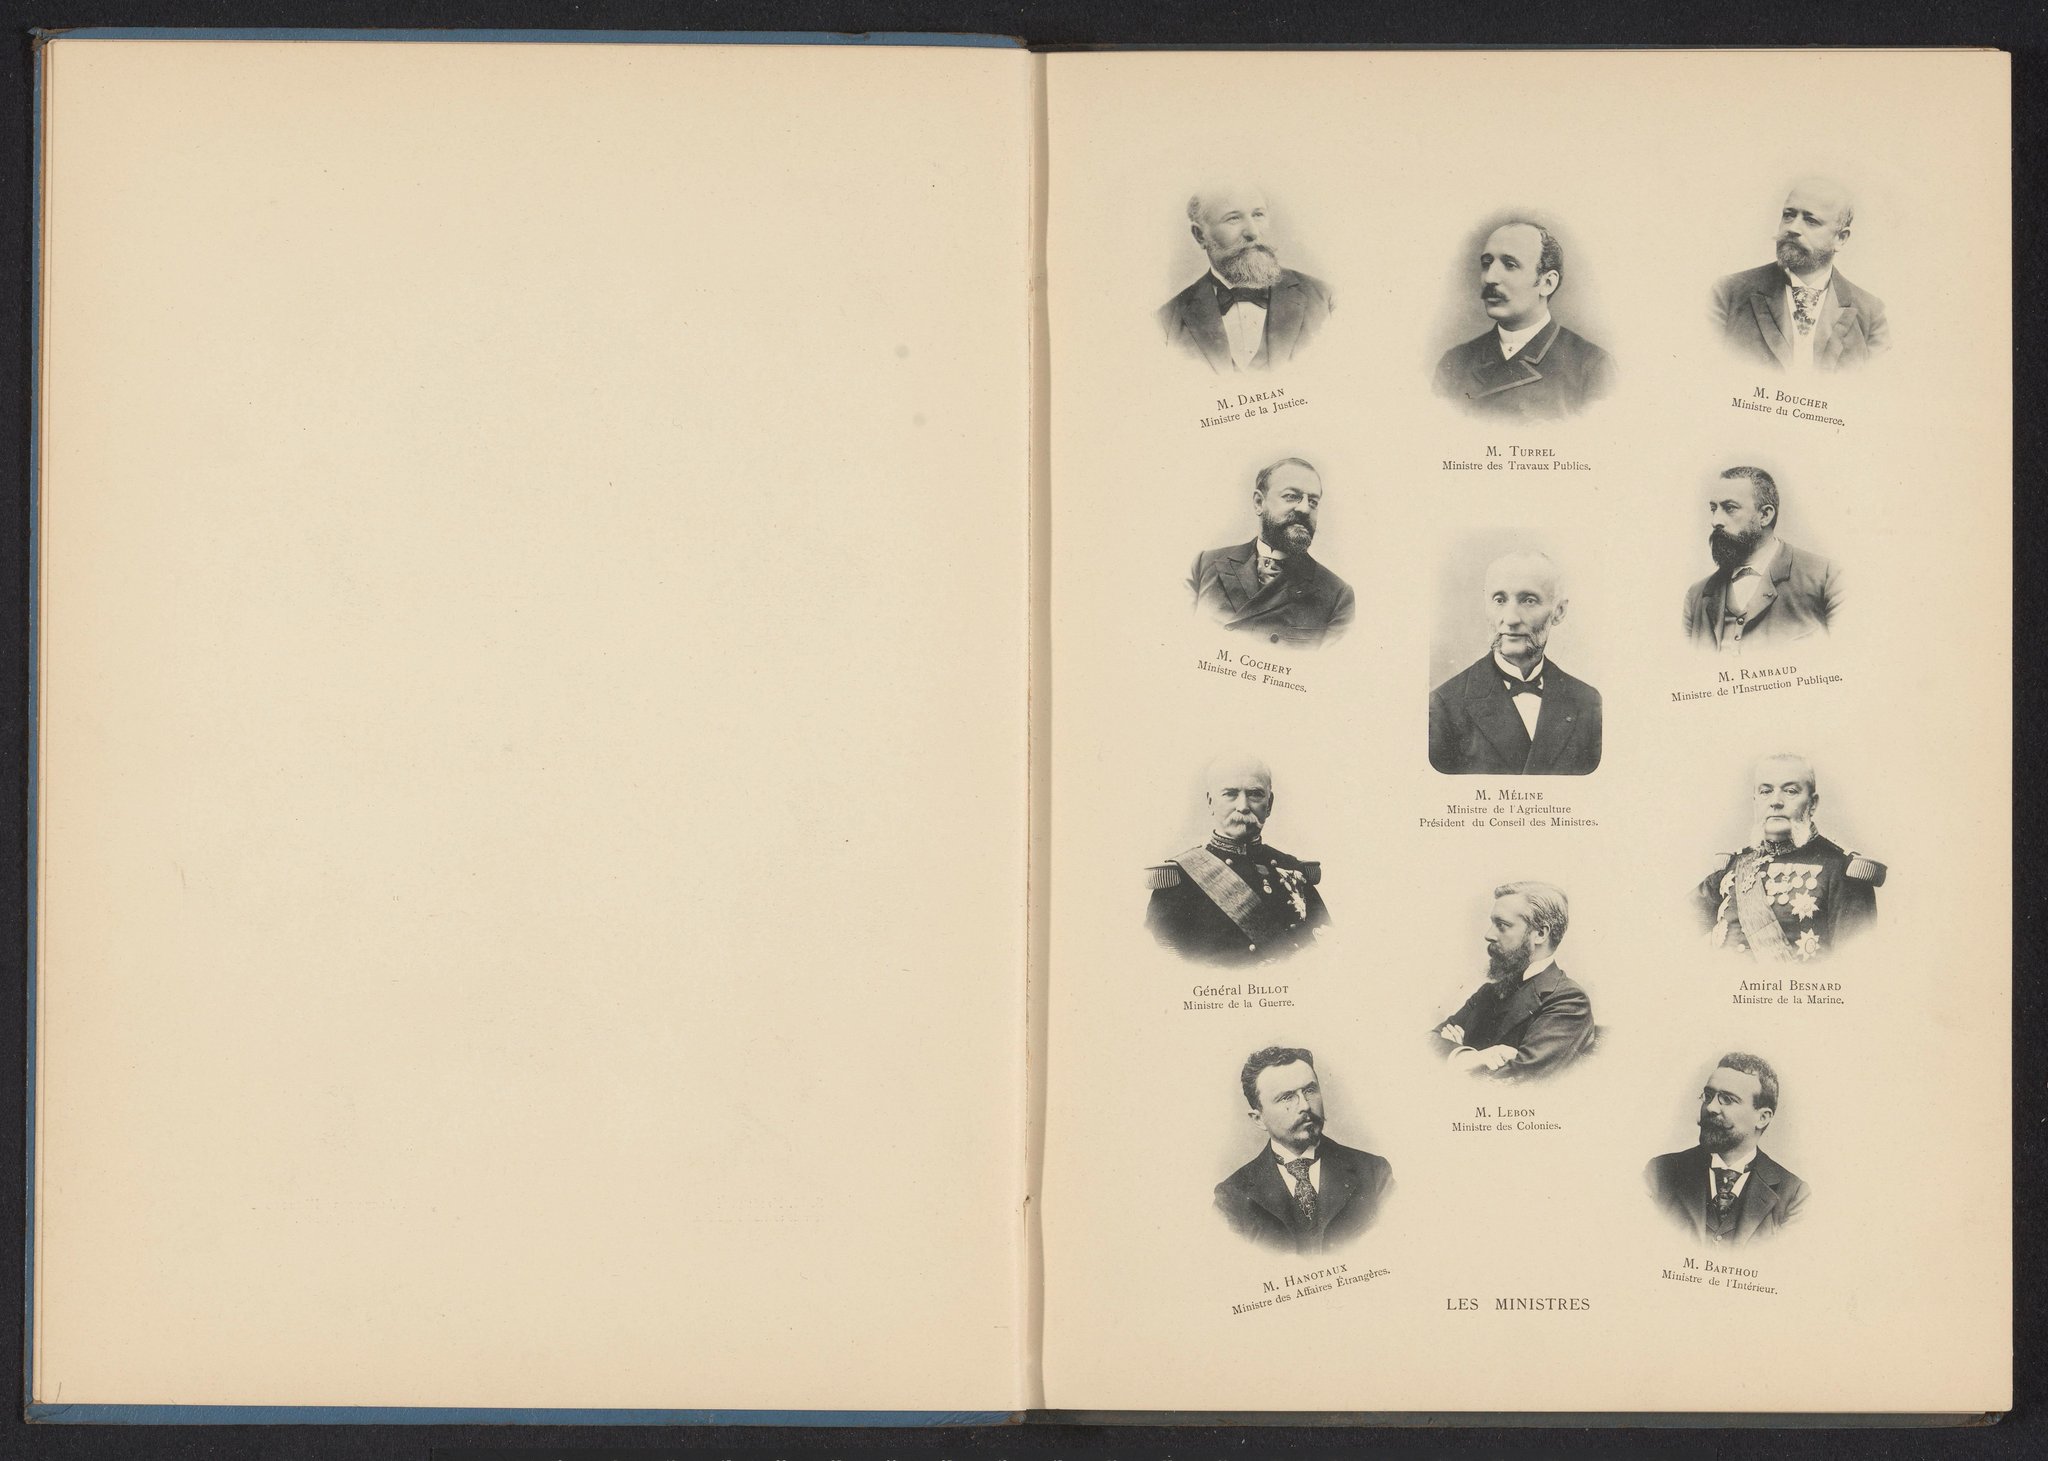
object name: page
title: Les ministres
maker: Anonymous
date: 1895-1897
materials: paper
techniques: photograph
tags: minister ~ government, historical persons (+ (full) bust portrait)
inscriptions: inscription: ‘M. Darlan (...) Ministre de l'Intérieur’